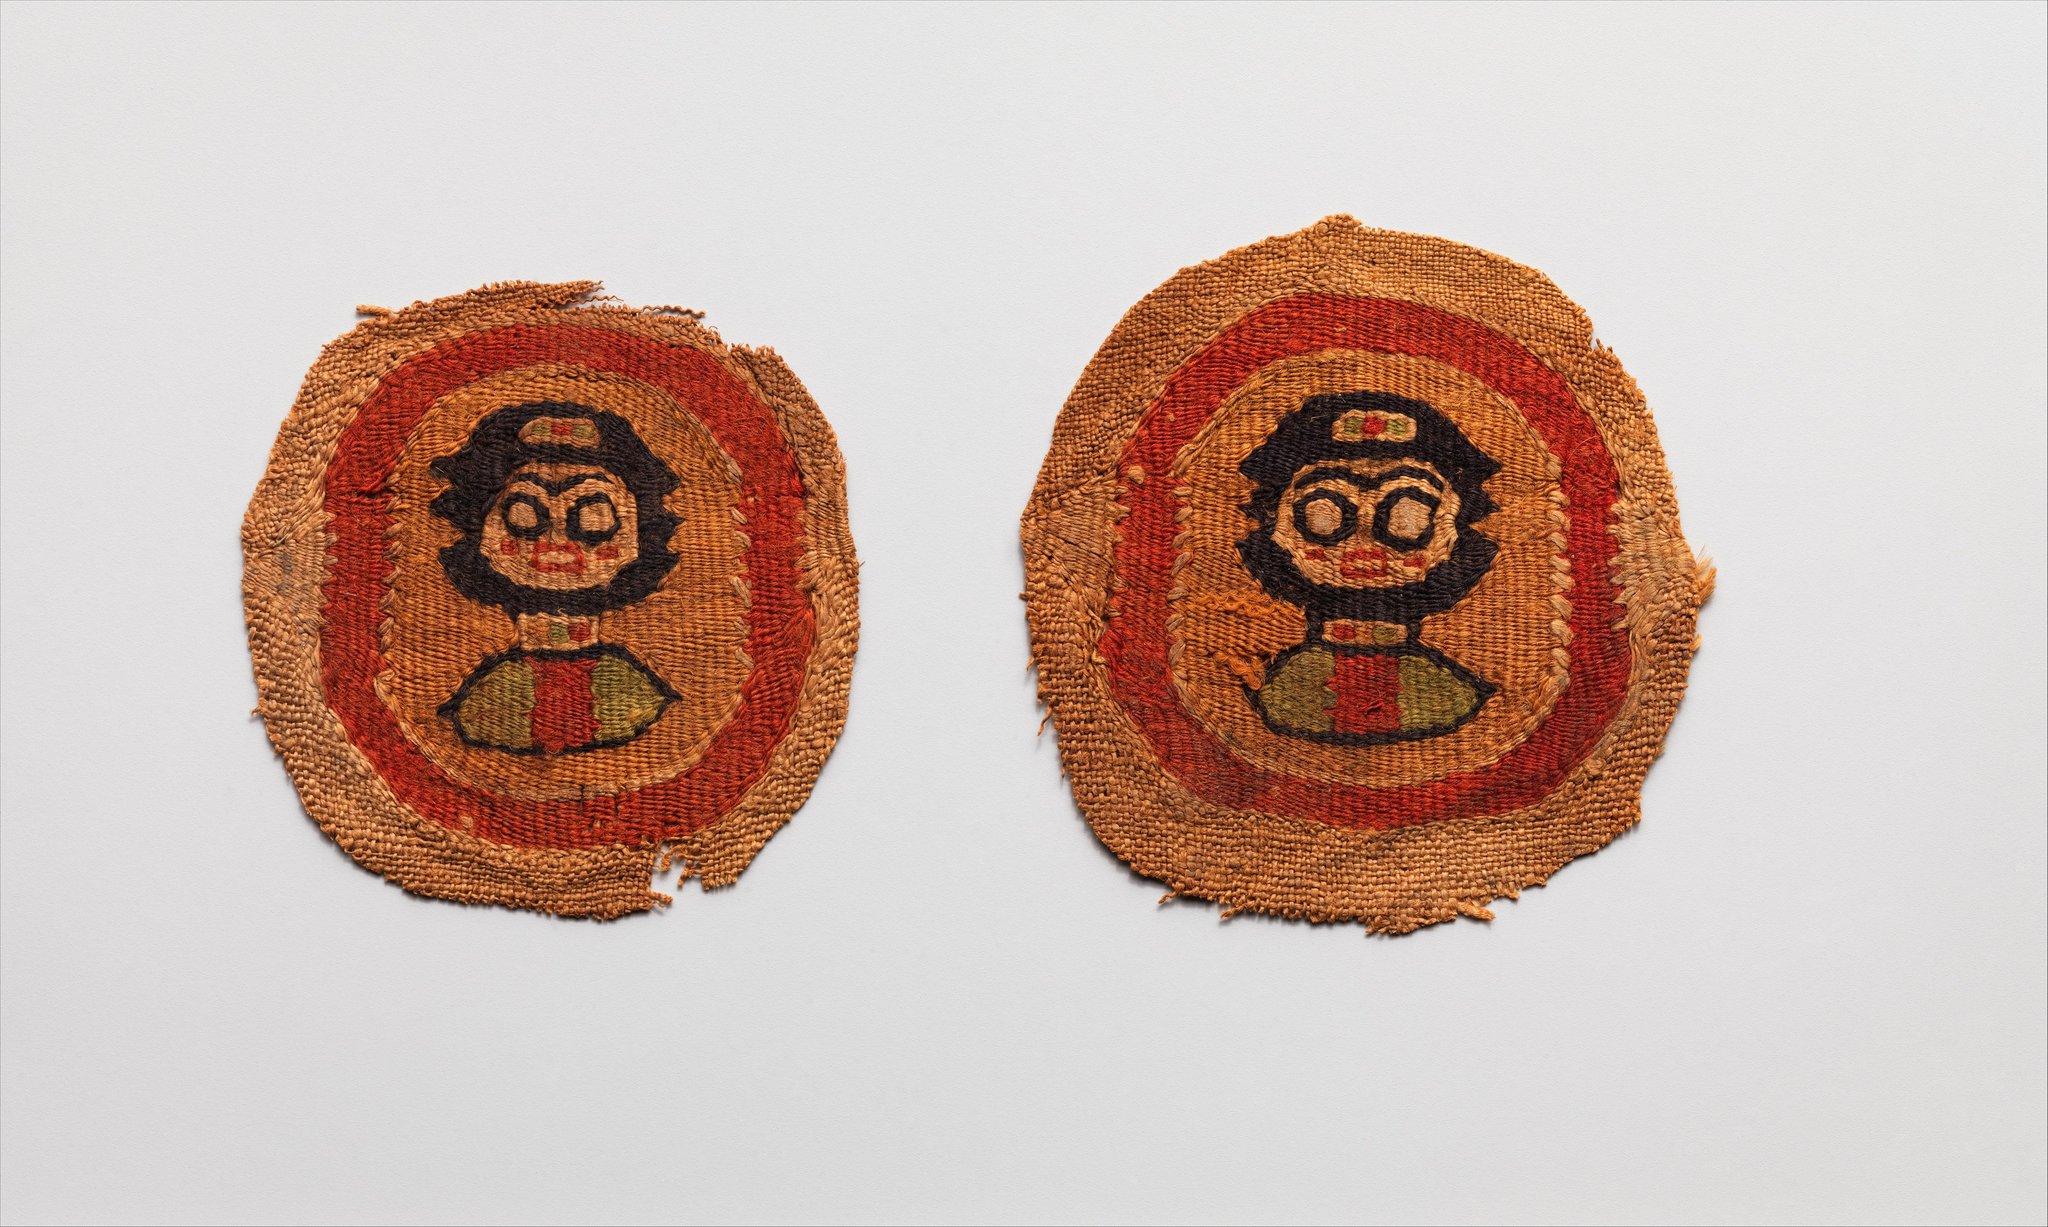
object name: textile fragment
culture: coptic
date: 501-600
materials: linen, wool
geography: egypt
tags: human figures